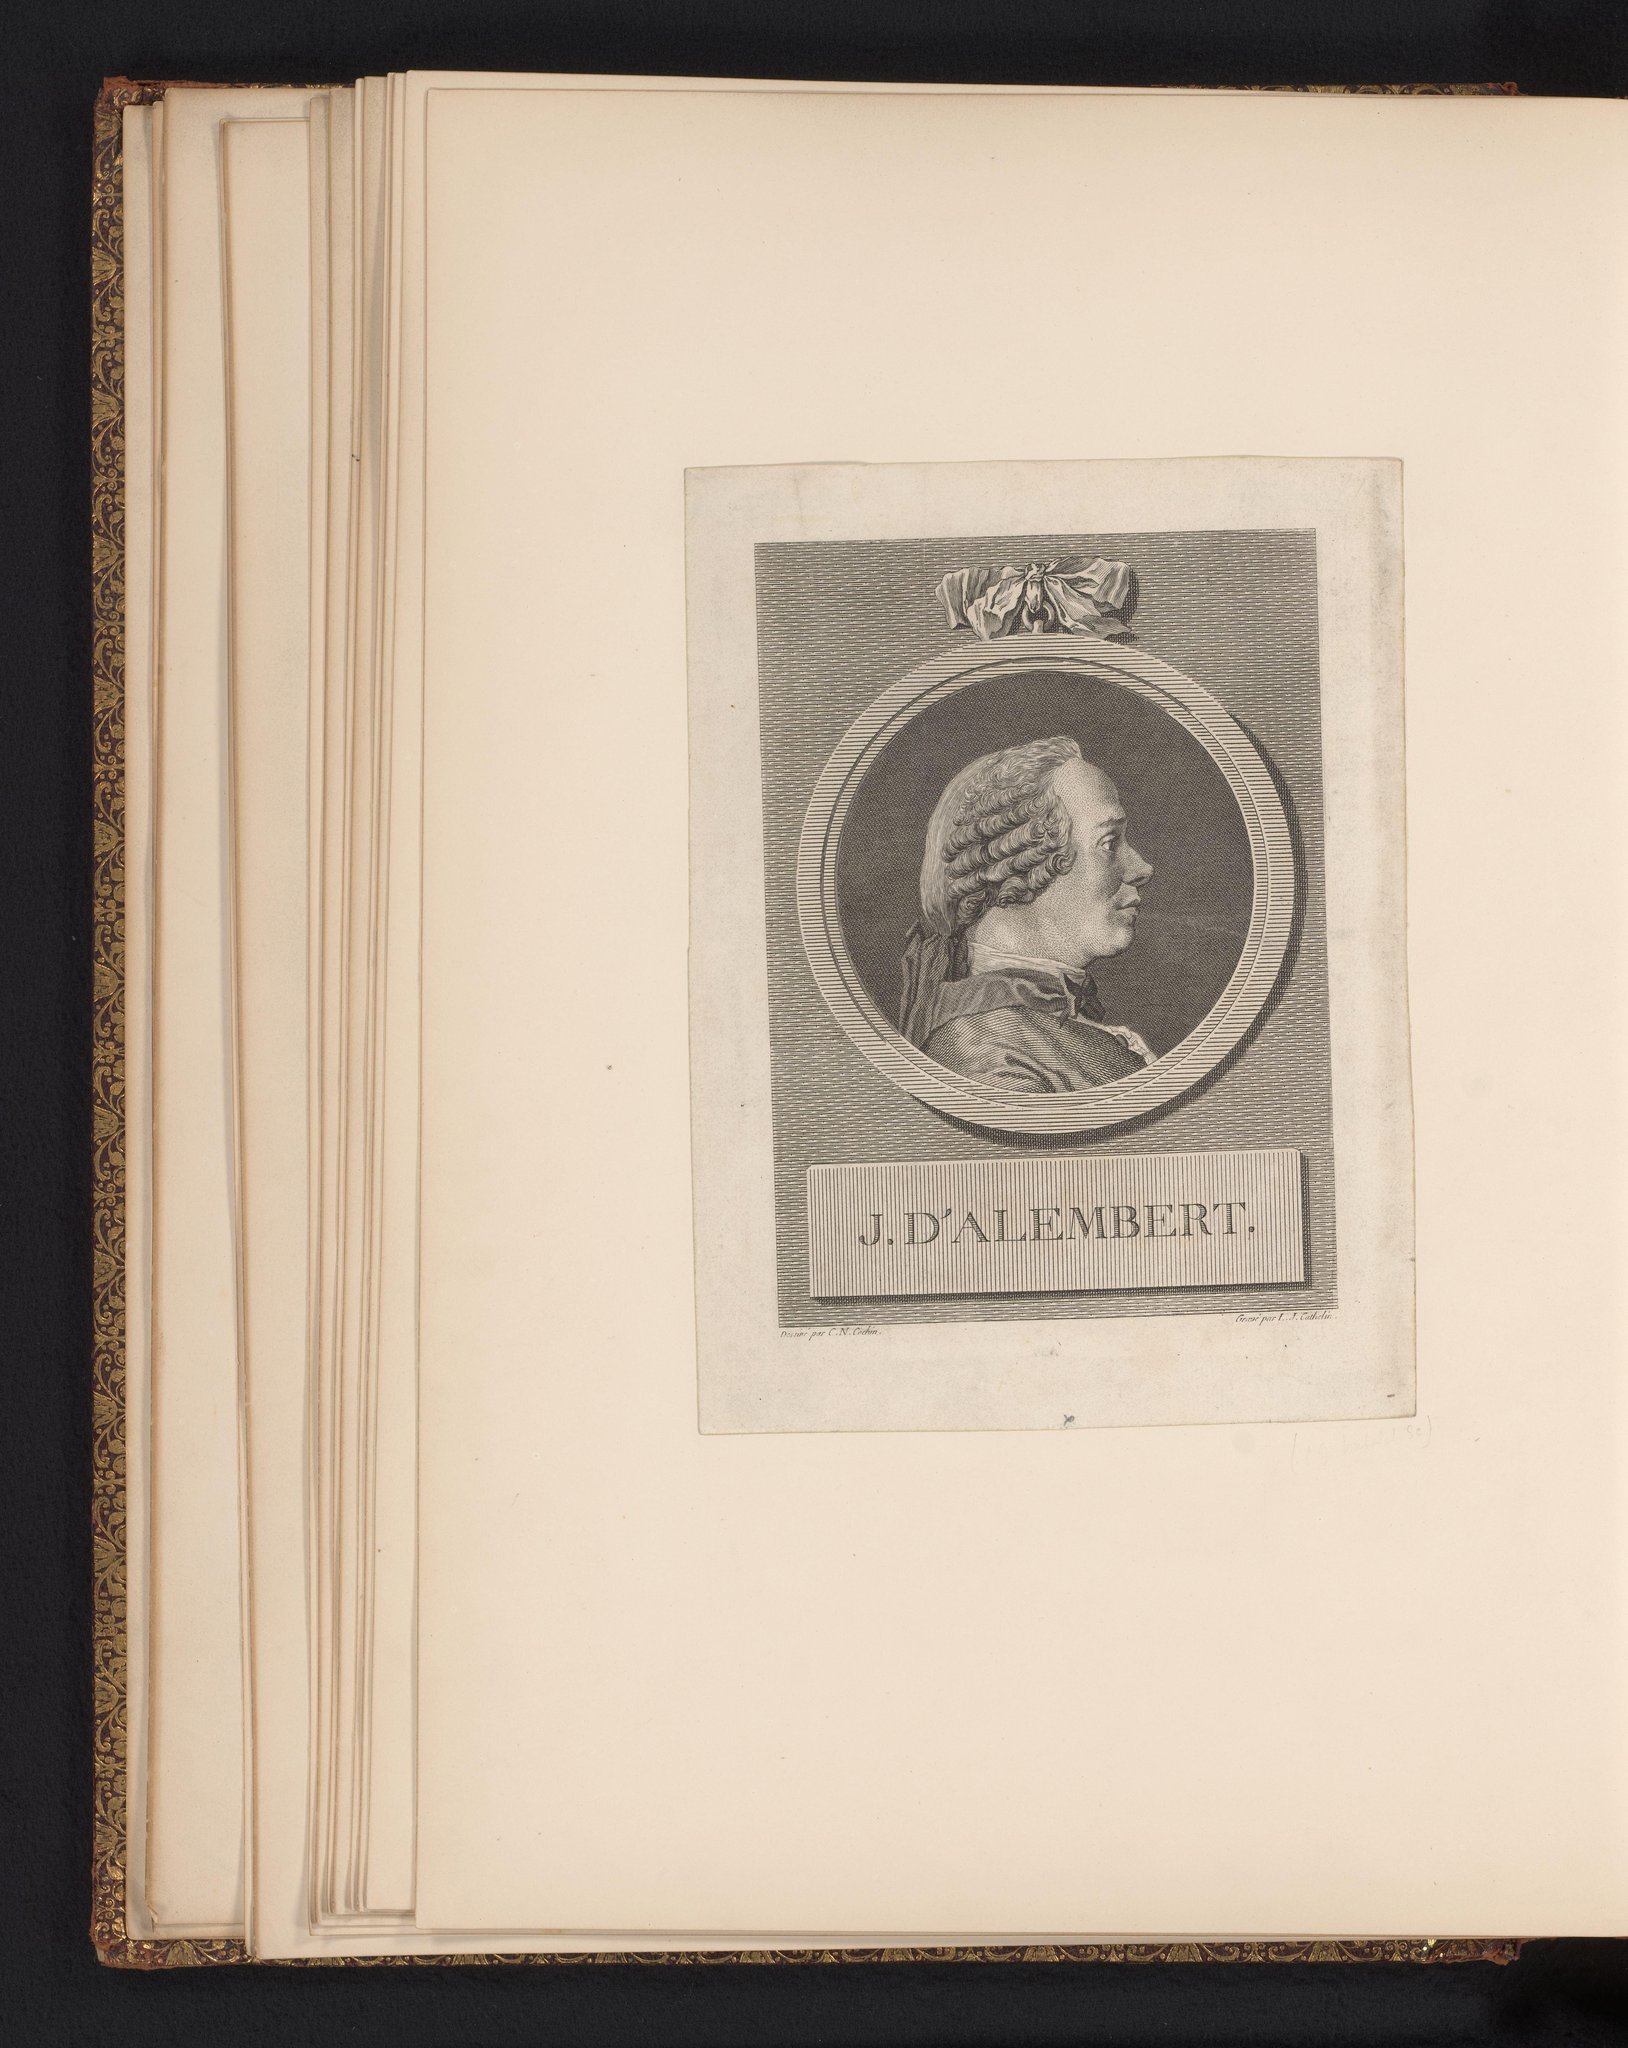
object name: album leaf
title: J. D'Alembert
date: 1755-1804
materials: paper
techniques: engraving, etching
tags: paris, physicist, scholar, philosopher, historical persons